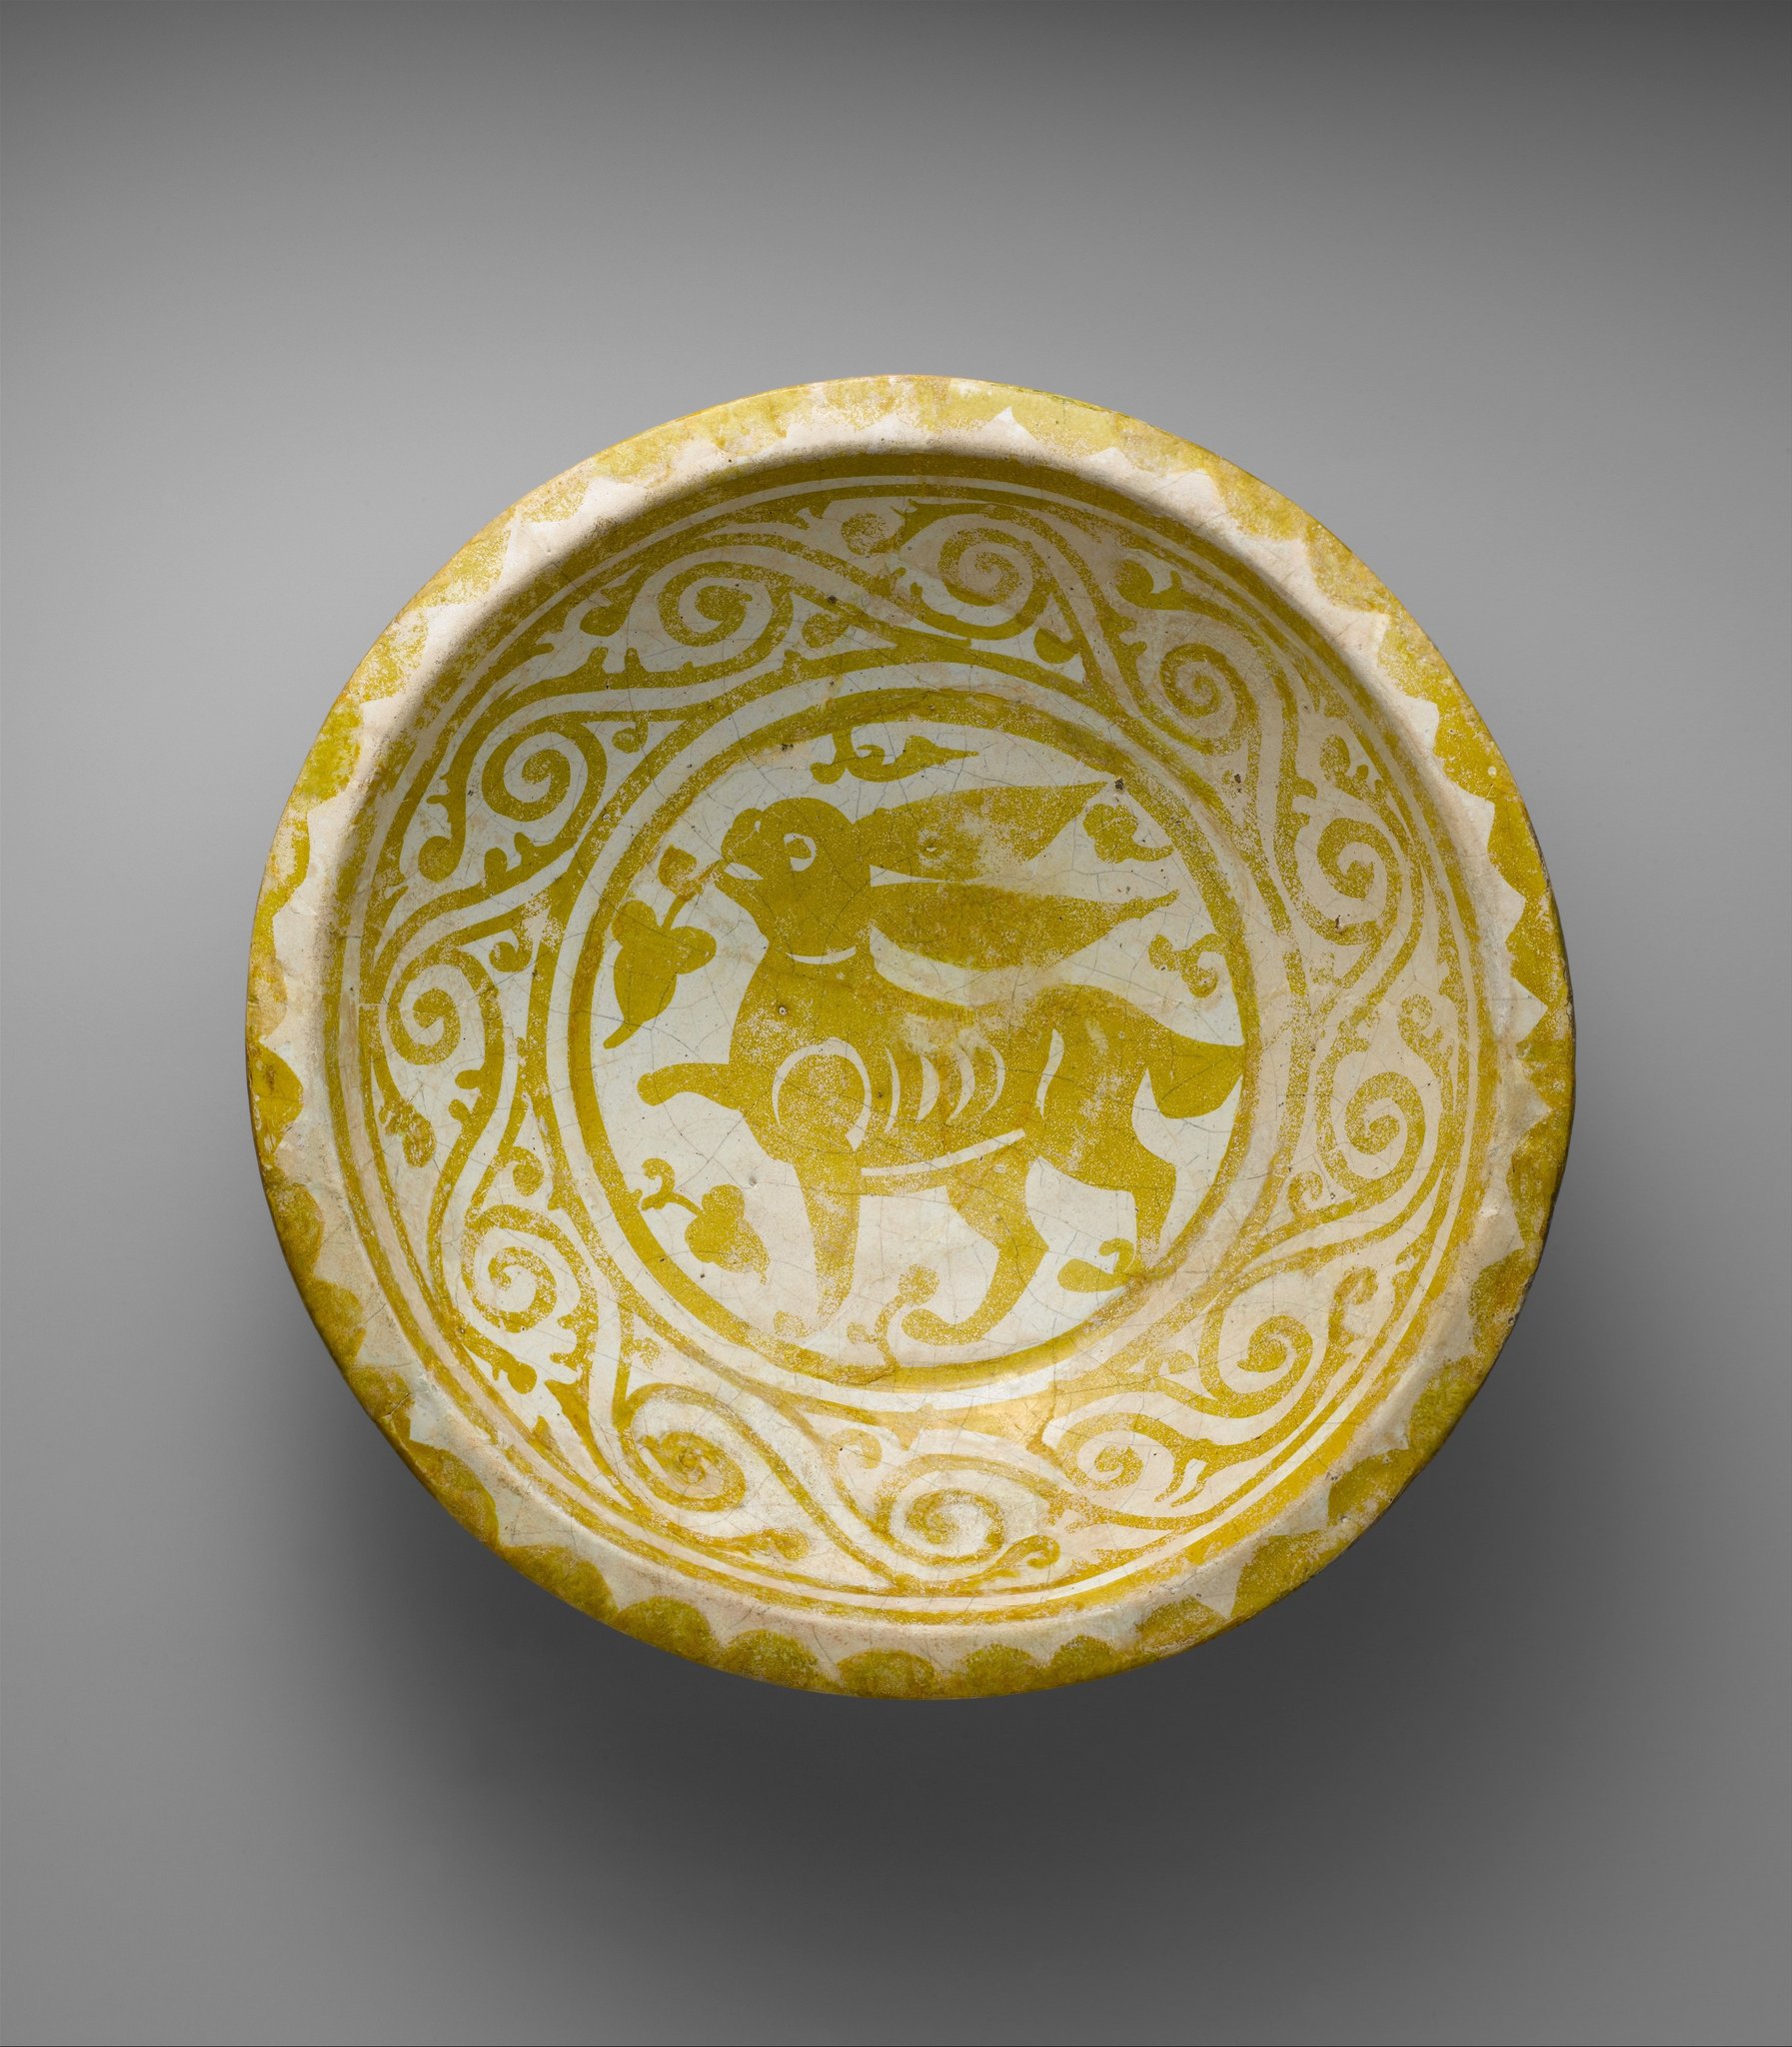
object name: bowl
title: Bowl Depicting a Running Hare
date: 1001-1025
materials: earthenware, glaze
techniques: luster painting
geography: egypt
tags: rabbits